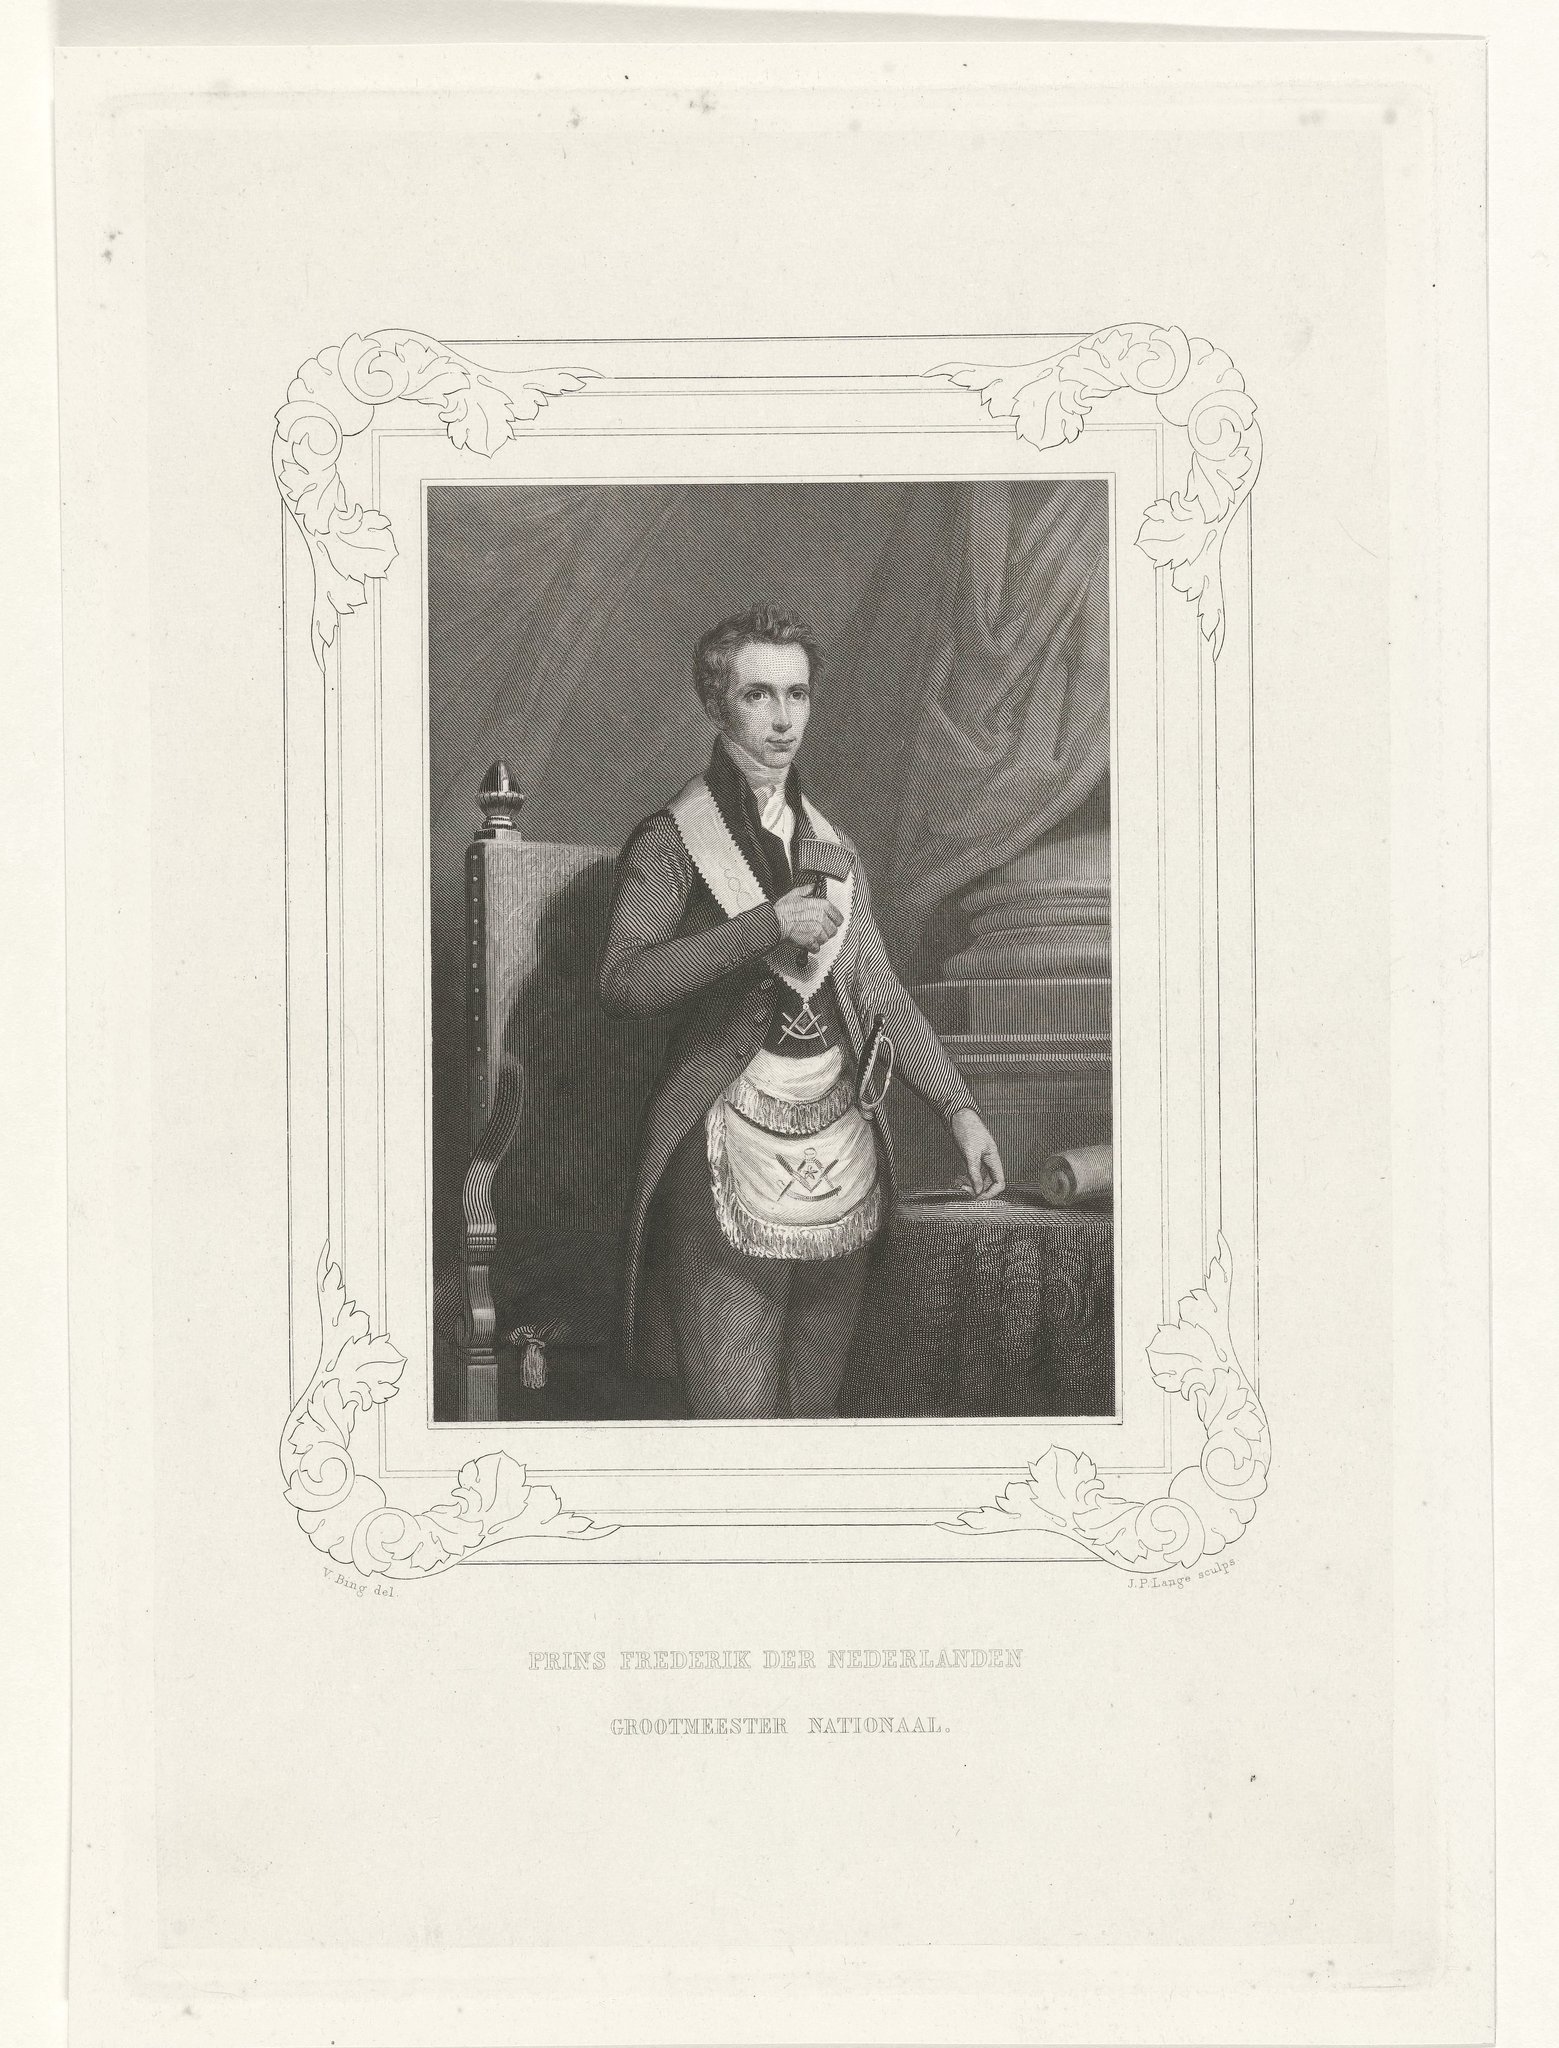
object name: print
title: Prins Frederik der Nederlanden, Grootmeester Nationaal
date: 1845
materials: paper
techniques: engraving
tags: berlin, frederik (prins der nederlanden)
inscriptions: collector's mark: Lugt 2228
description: Portret van prins Frederik der Nederlanden. Kniestuk, staande naast een tafel. Om zijn hals hangt het symbool van de Vrijmetselarij, ook op zijn schort prijkt dit symbool. Rondom het portret een opengewerkte sierrand.